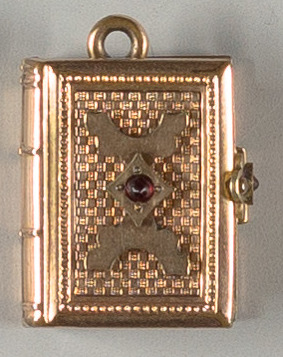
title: Locket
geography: europe